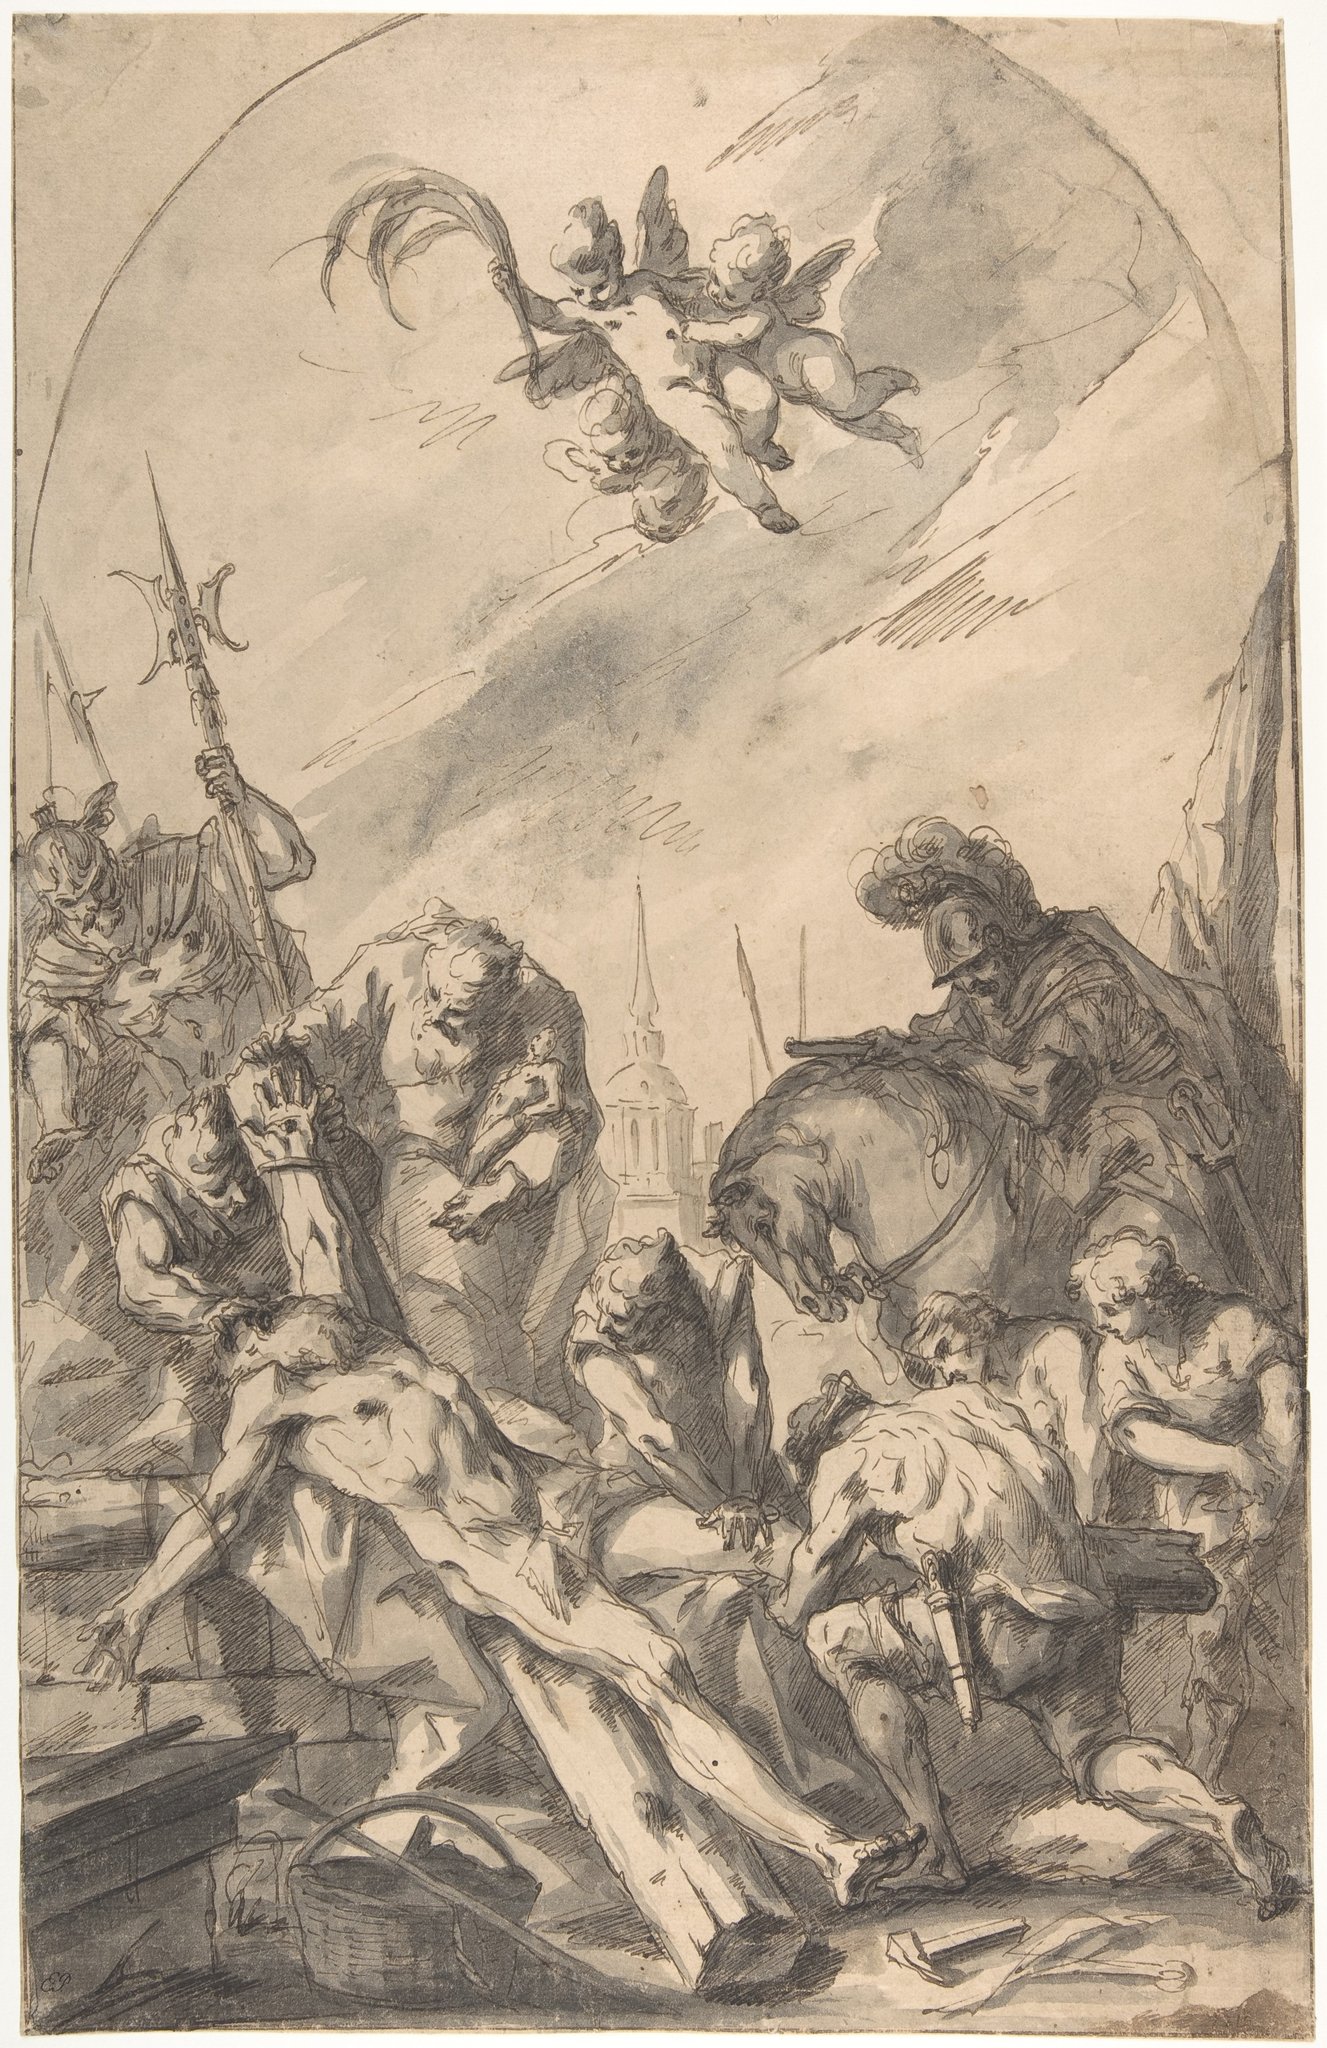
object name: drawing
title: The Martyrdom of Saint Andrew (recto); Back of a Woman Wearing a Long Dress with a Ruff (verso)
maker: gaspare diziani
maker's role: artist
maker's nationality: italian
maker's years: 1689-1767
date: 1689-1767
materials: graphite, ink, lead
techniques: brush, drawing, pen, wash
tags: weapons,women,cupid,horses,saints